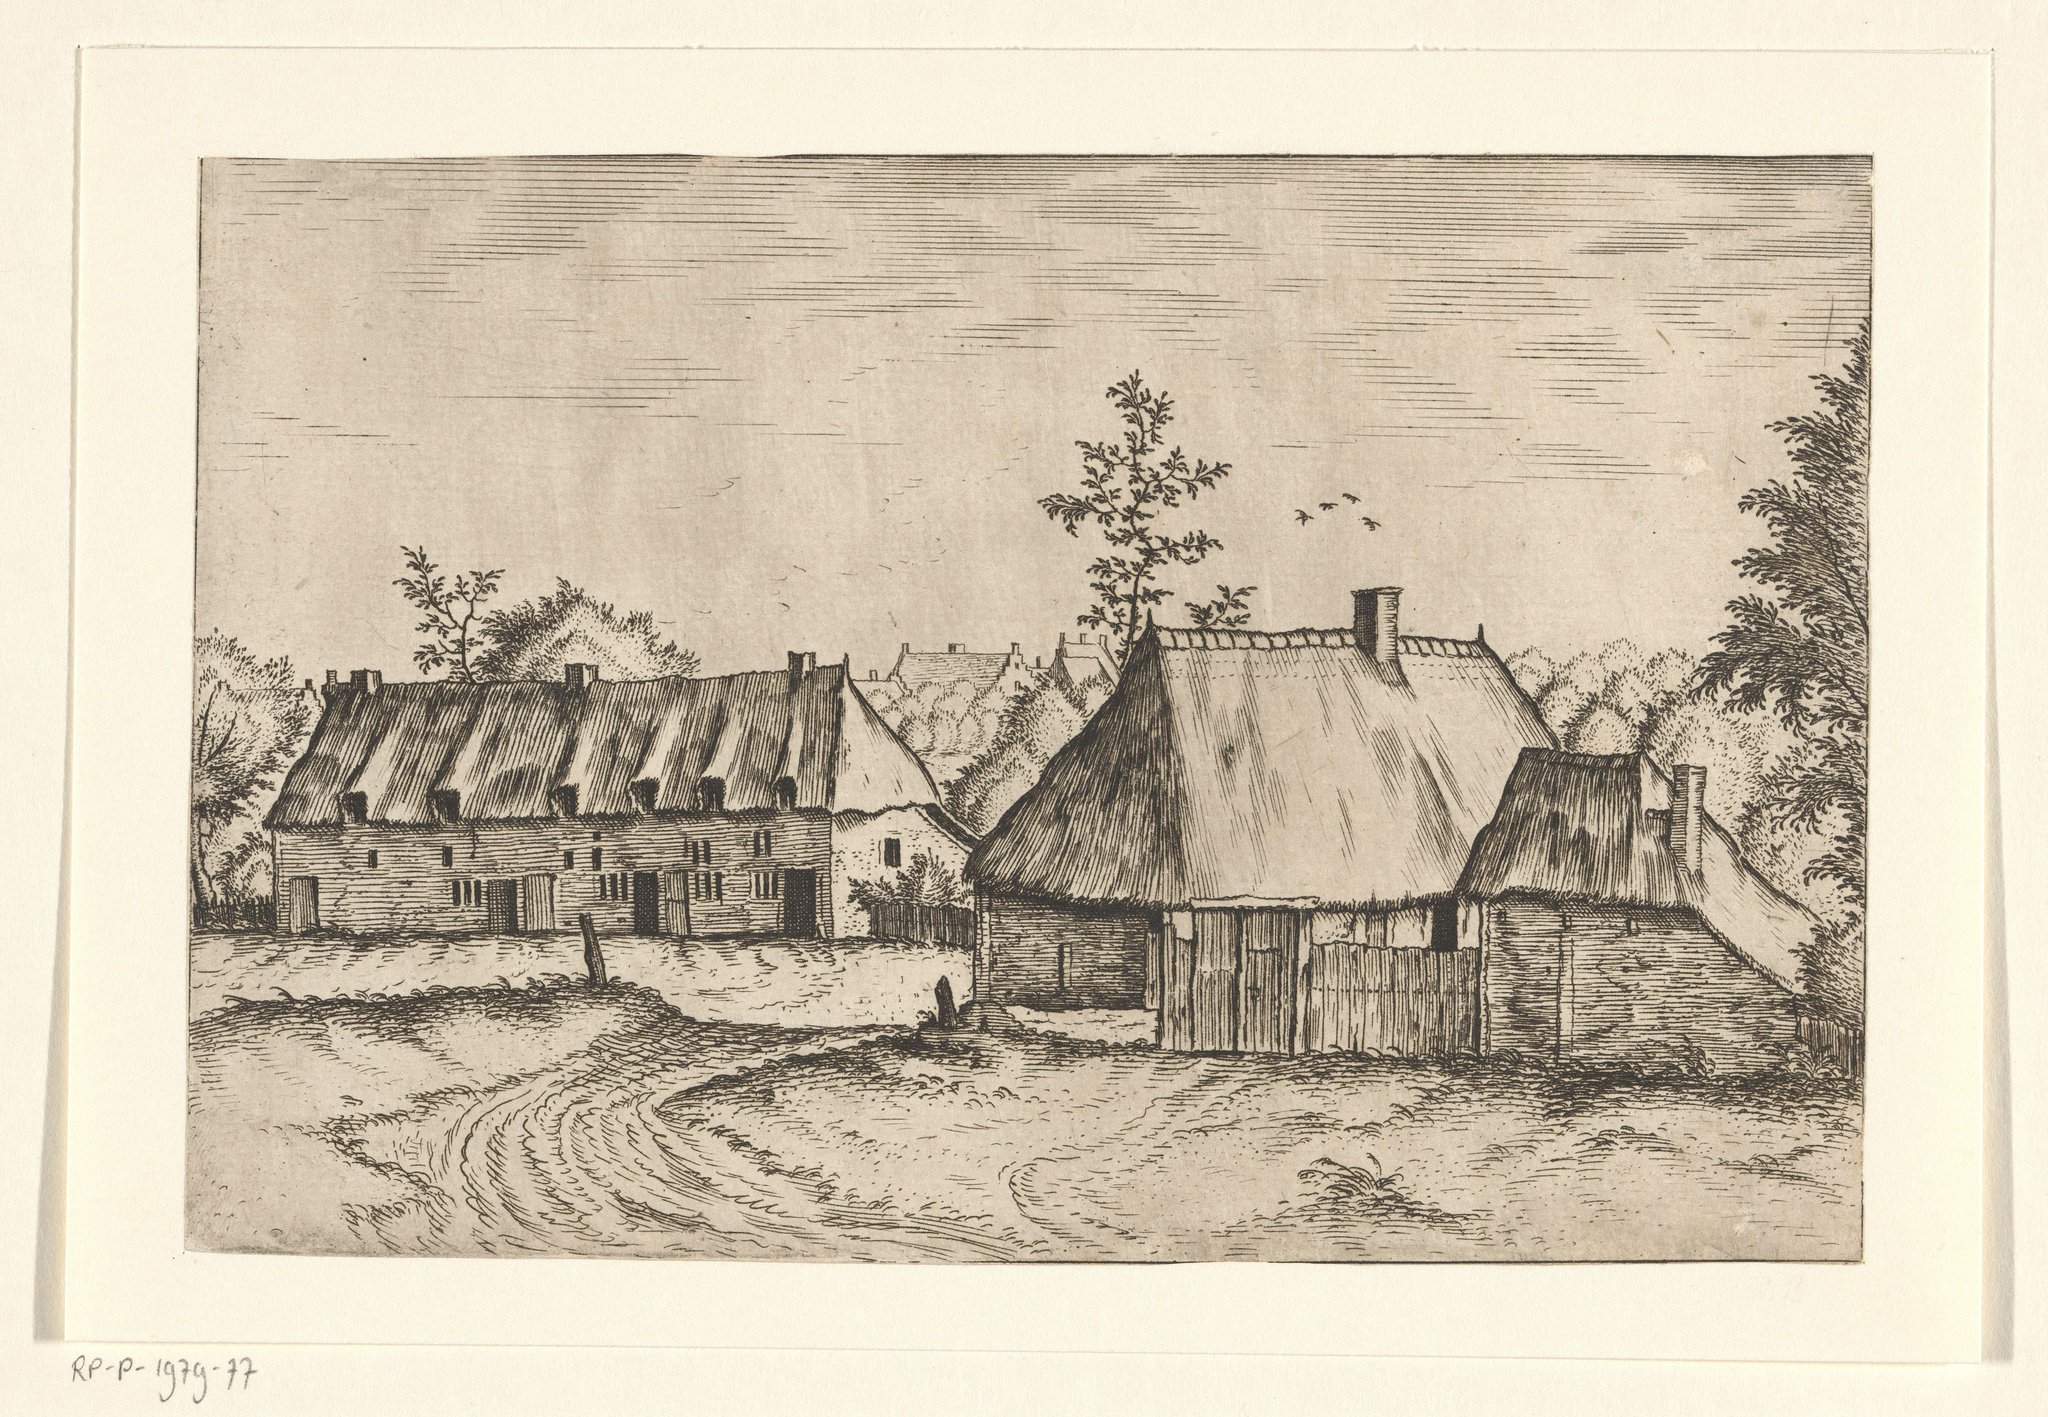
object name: print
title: Kleine landschappen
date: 1559-1561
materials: paper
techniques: etching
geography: antwerp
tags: the usual house or row of houses, farm (building)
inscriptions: collector's mark: Lugt 2760, collector's mark: Lugt 2228